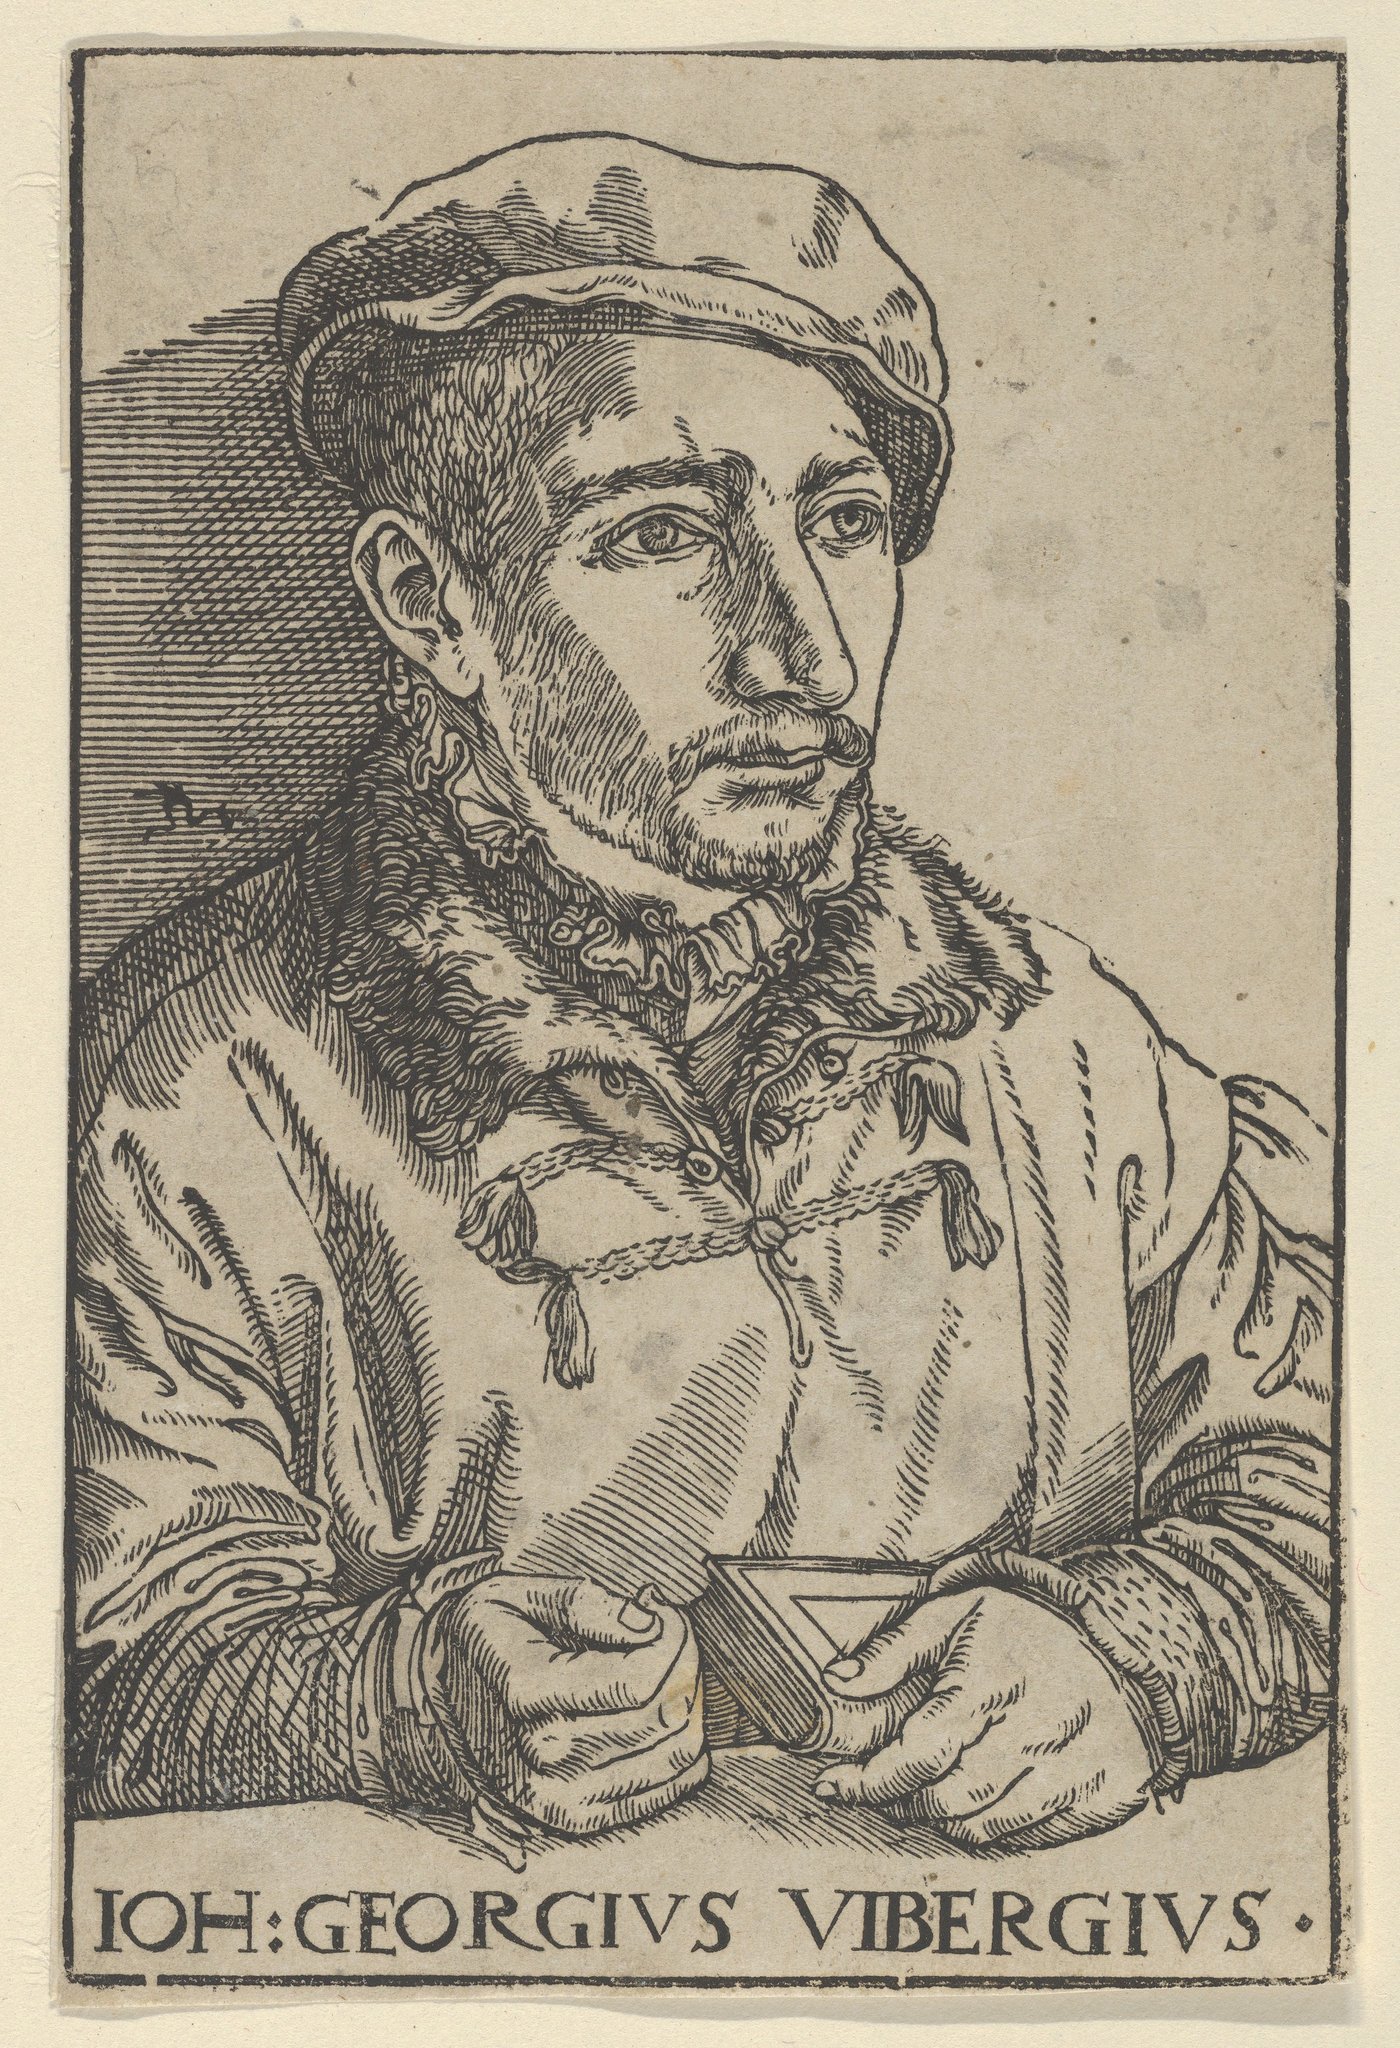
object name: print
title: Portrait of Johann Georg Viberg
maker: lucas cranach the younger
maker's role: artist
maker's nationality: german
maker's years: 1515-1586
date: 1515-1586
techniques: woodcut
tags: men,portraits